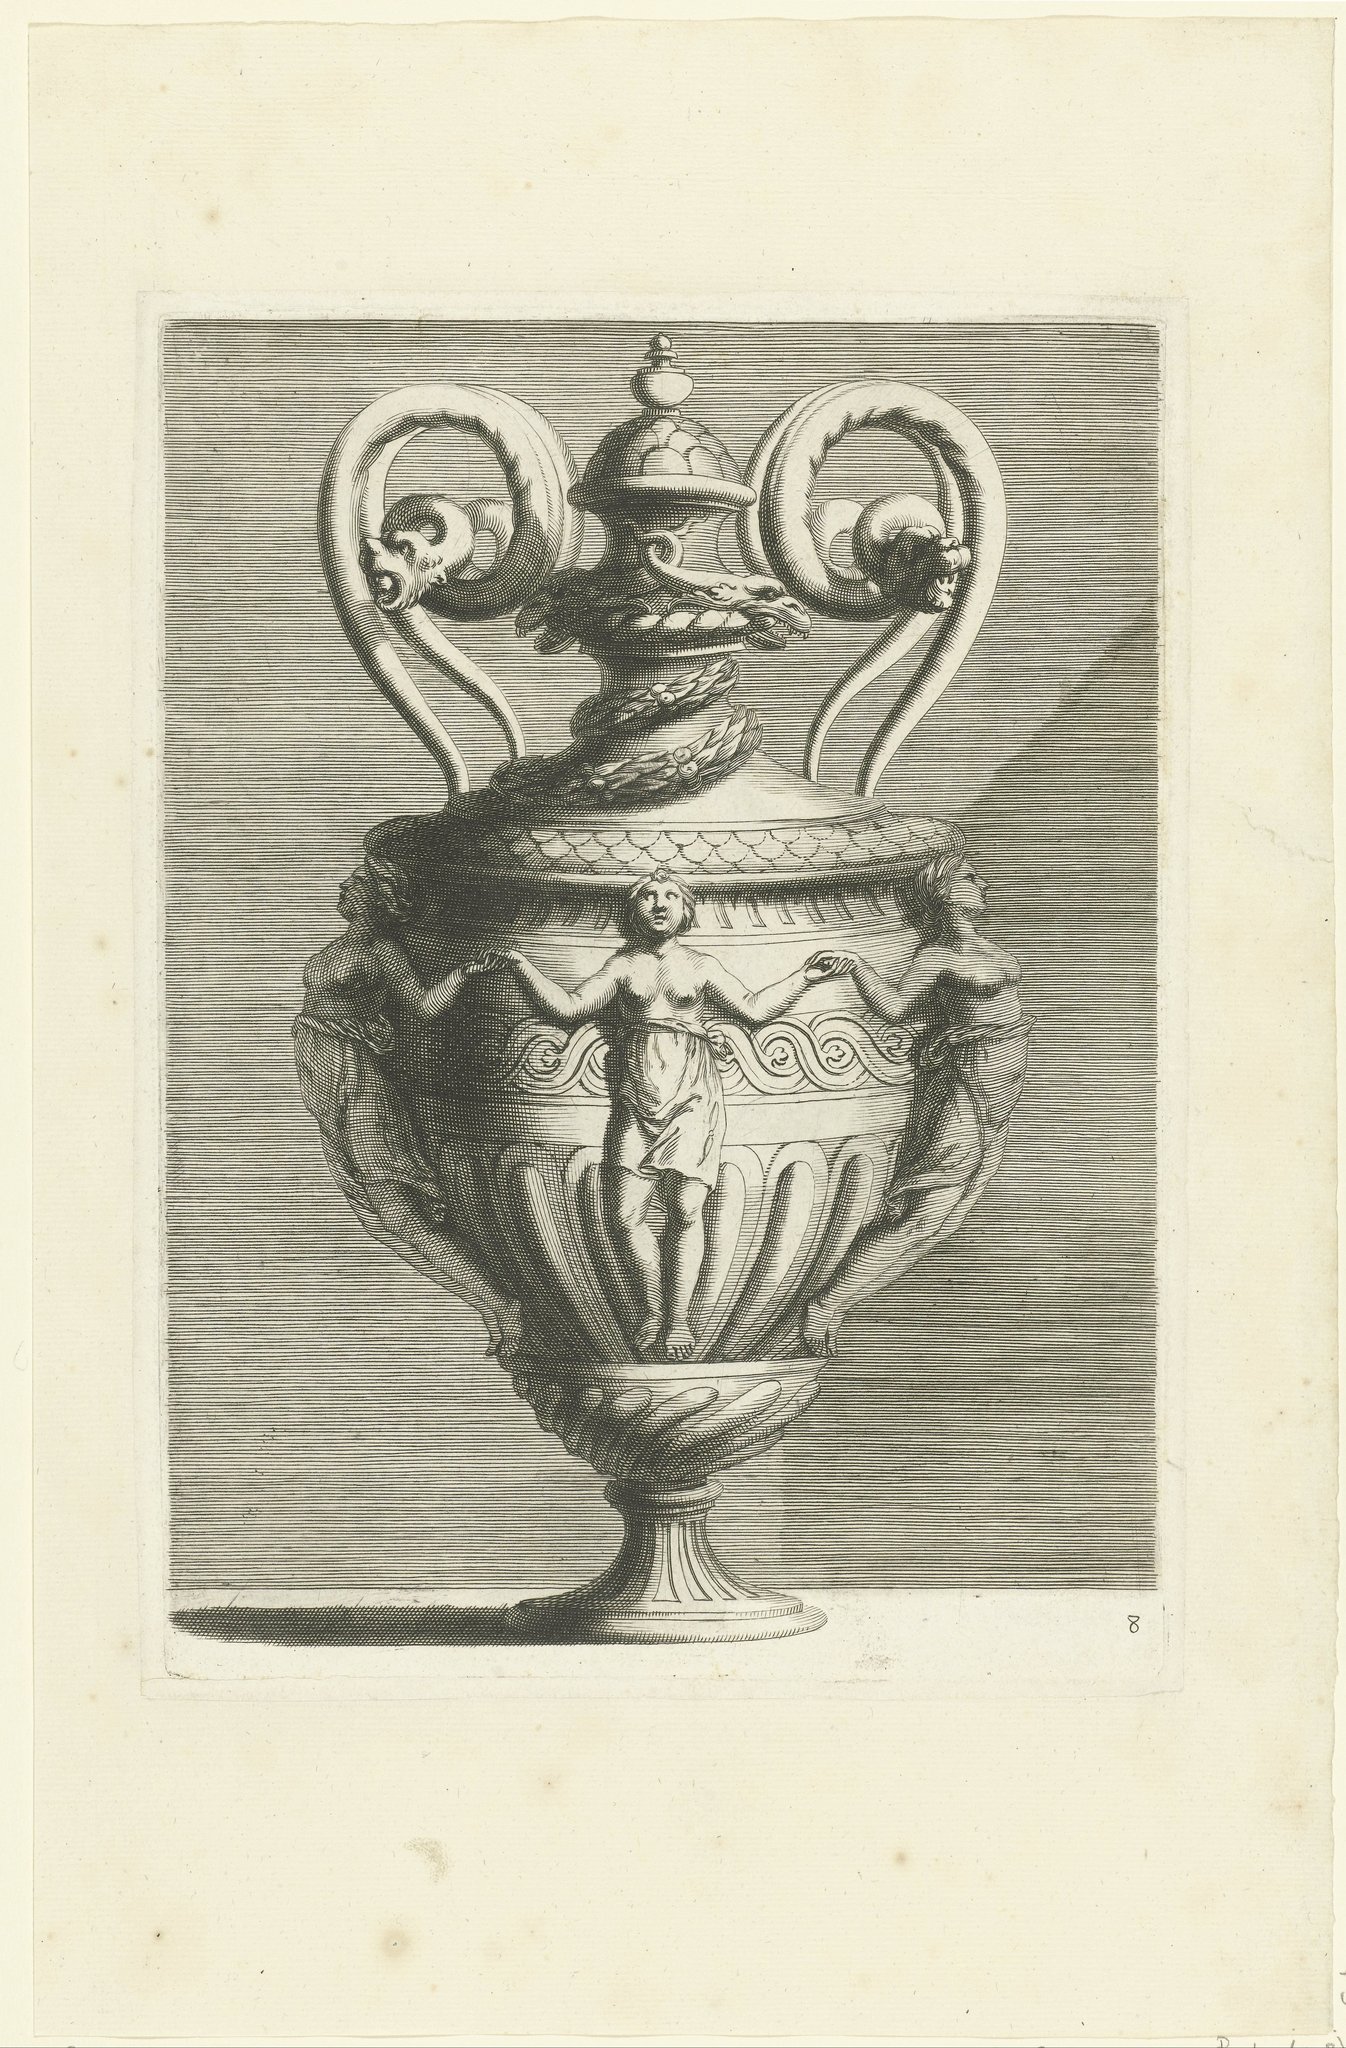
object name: print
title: Vaas met deksel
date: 1657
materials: paper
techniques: engraving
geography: france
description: Het lichaam is gedecoreerd met een eierlijst en drie vrouwen, op de deksel bijten twee slangen in een kabel. Blad 8 uit serie van 24 bladen, genummerd: 1-21, 23-25.